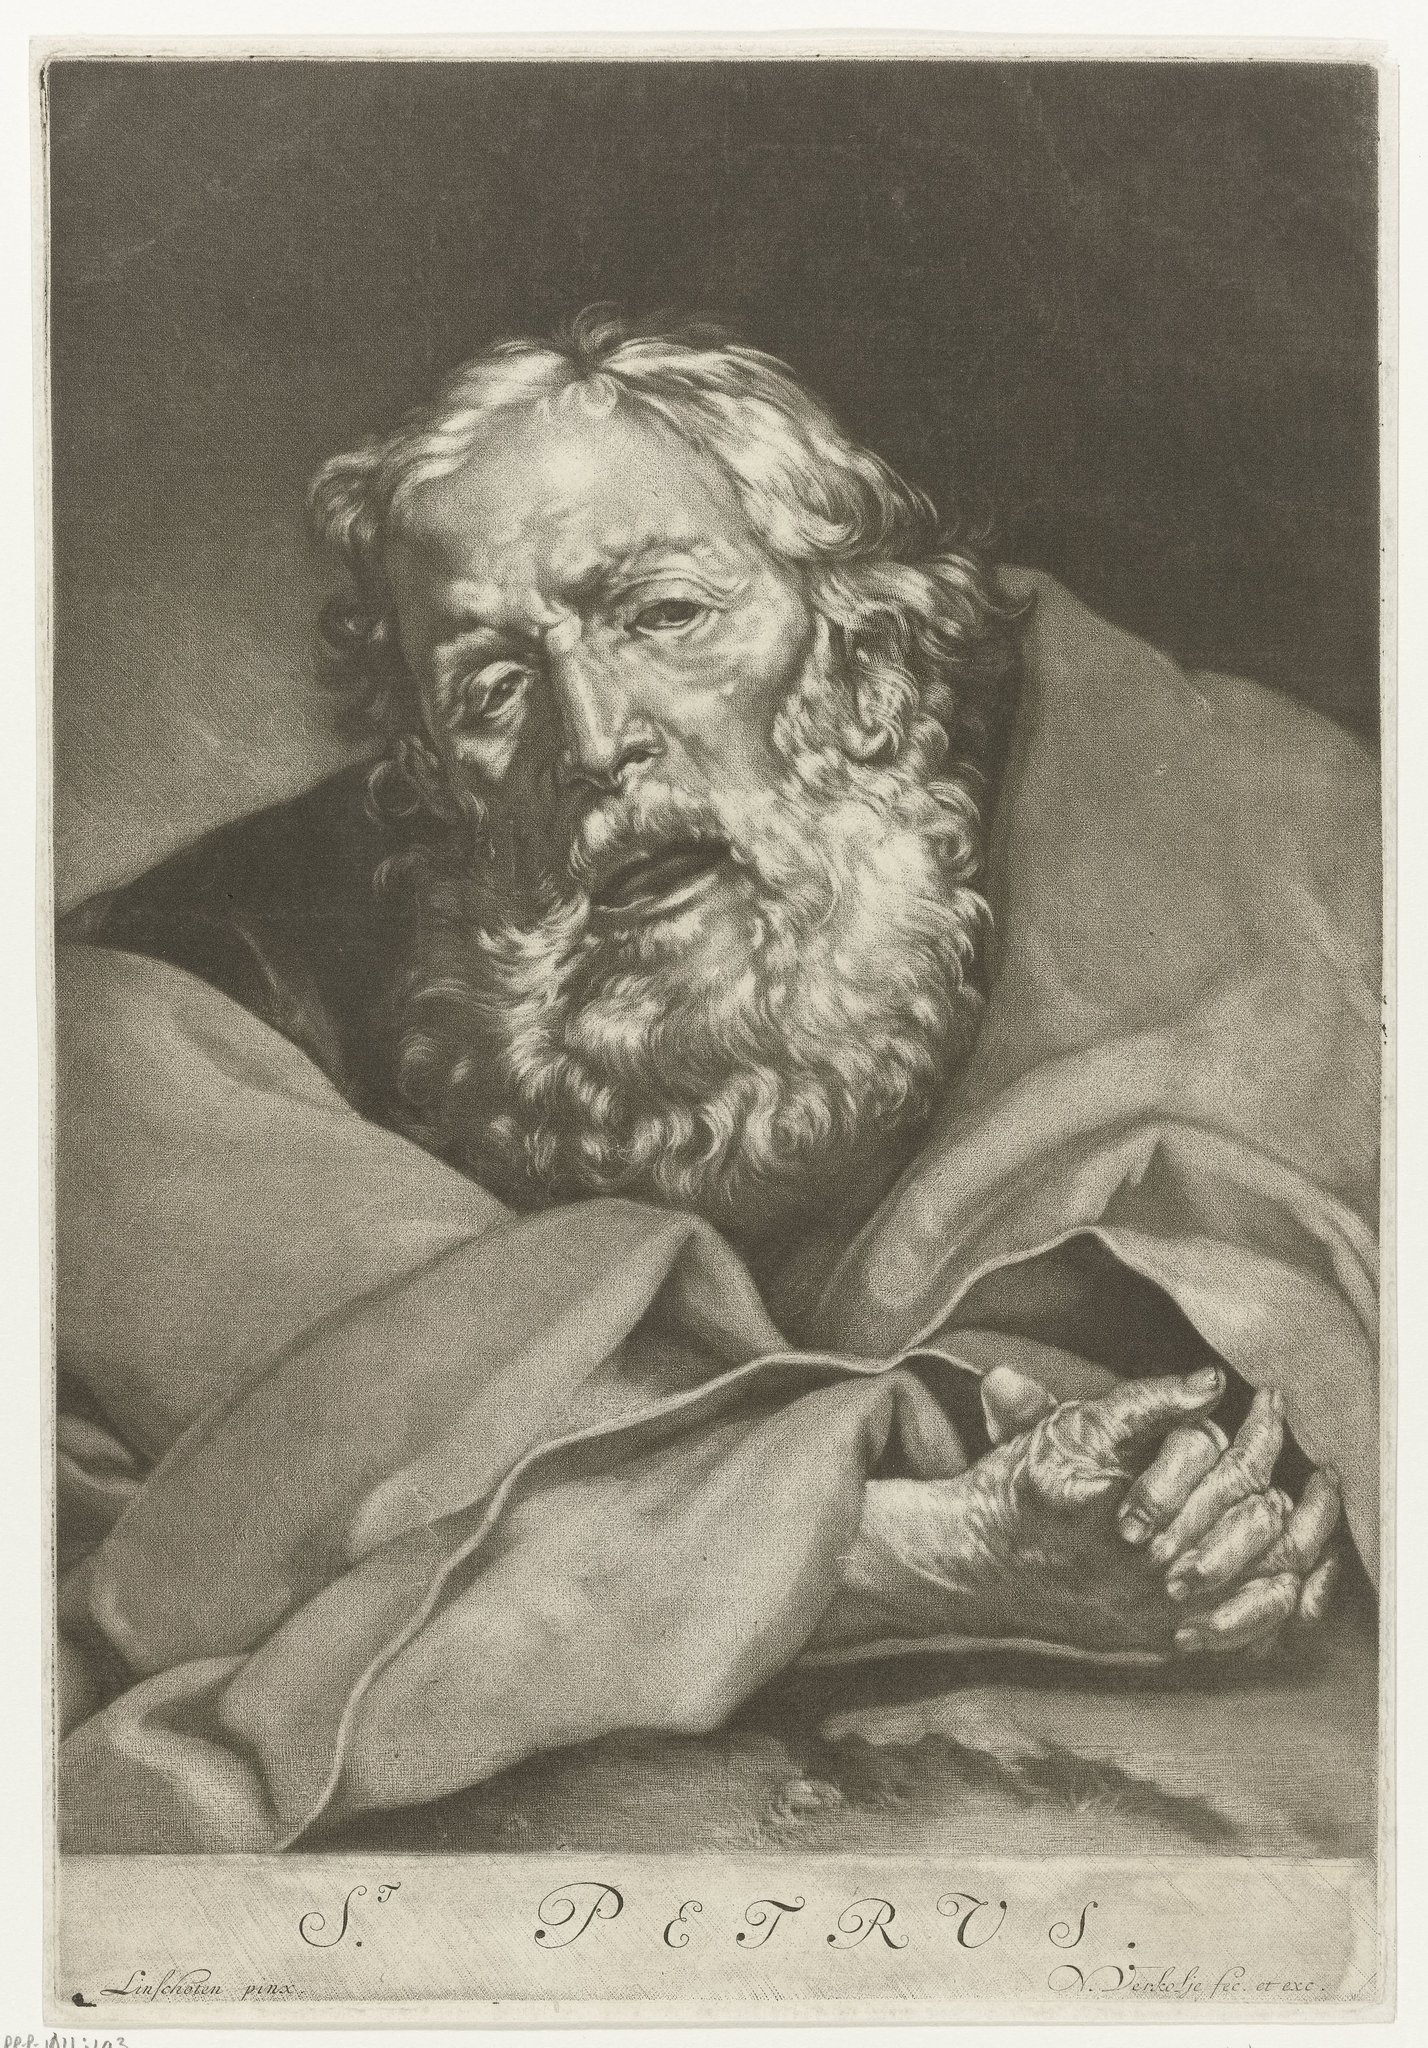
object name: print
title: Boetvaardige Petrus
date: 1683-1746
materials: paper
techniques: mezzotint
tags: the apostle peter, first bishop of rome; possible attributes: book, cock, (upturned) cross, (triple) crozier, fish, key, scroll, ship, tiara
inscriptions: collector's mark: Lugt 2228